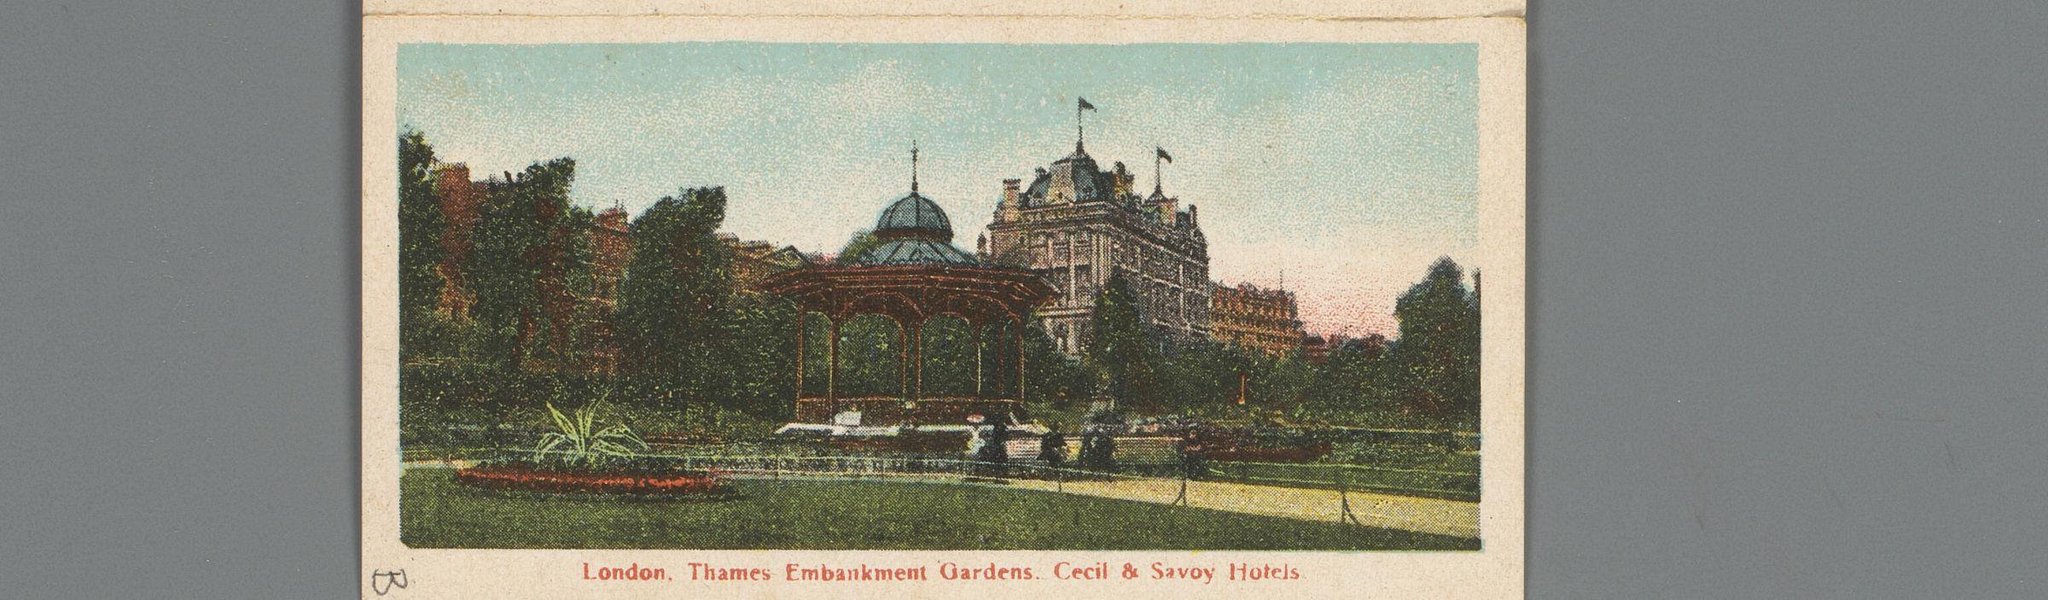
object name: album leaf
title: London. Thames Embankment Gardens. Cecil & Savoy Hotels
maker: Anonymous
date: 1888-1914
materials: paper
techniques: autotype, chromophotolithography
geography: london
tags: public gardens, park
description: Deze prent maakt deel uit van een album.